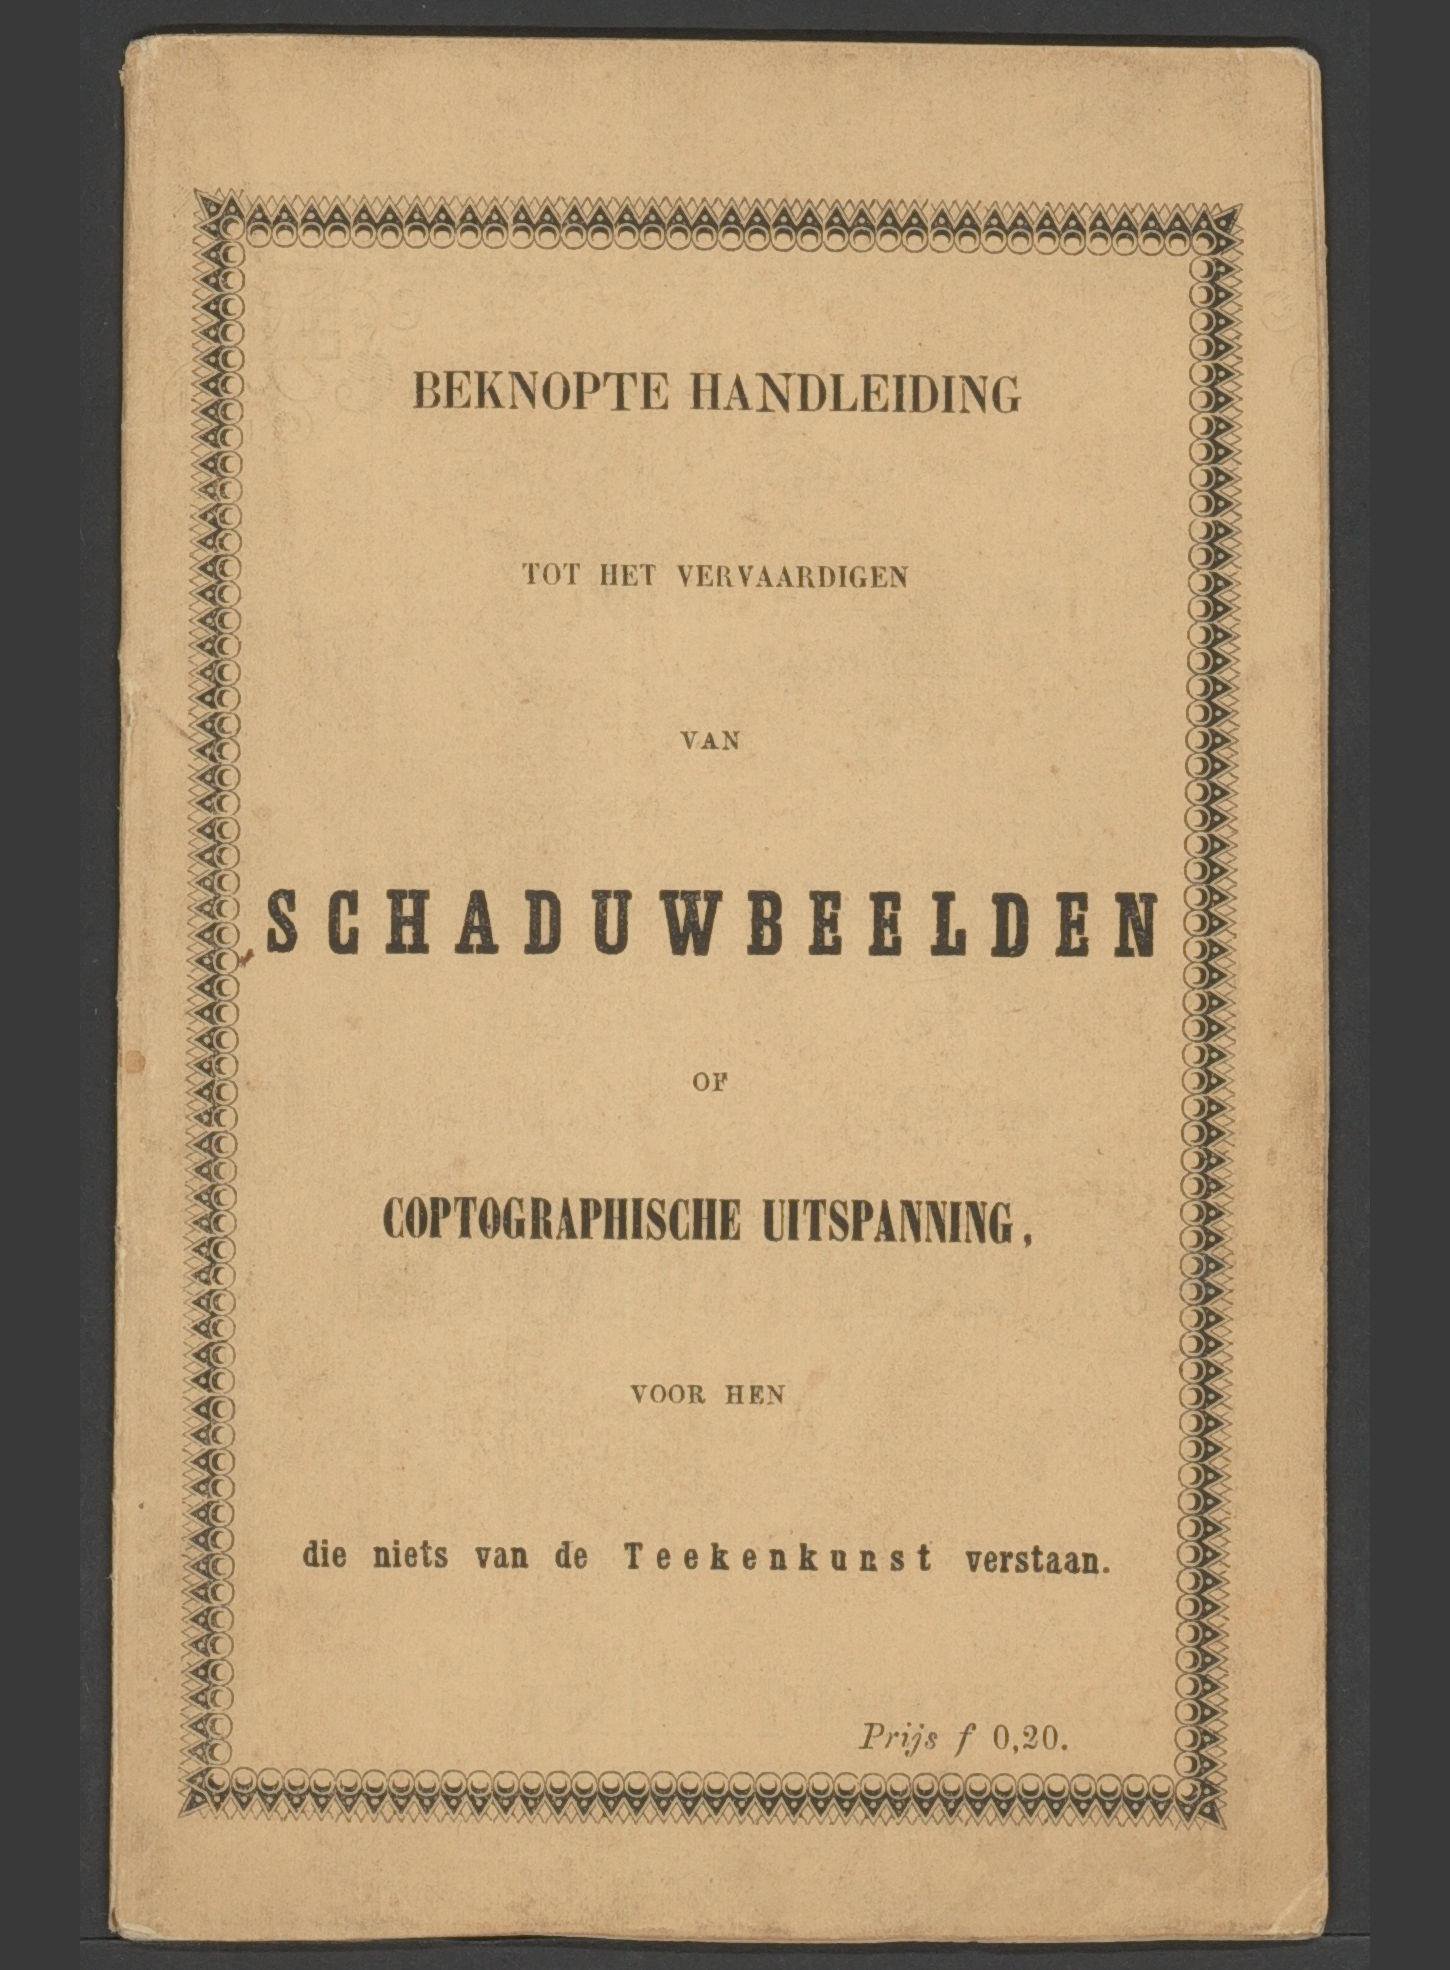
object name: manual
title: Handleiding voor het vervaardigen van schaduwbeelden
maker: Anonymous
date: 1851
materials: paper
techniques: letterpress printing, lithograph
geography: utrecht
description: Handleiding voor het vervaardigen van schaduwbeelden. De handleiding van vijf gevouwen bladen en een omslag. De bladen zijn aan beide kanten bedrukt. De achterste pagina is uit te vouwen. Hier staan diverse afbeeldingen op die de tekst begeleiden. Onderwerpsrubrieken binnen de Atlas Zeden en Gewoonten: Schoone kunsten, Silhouetportretten.